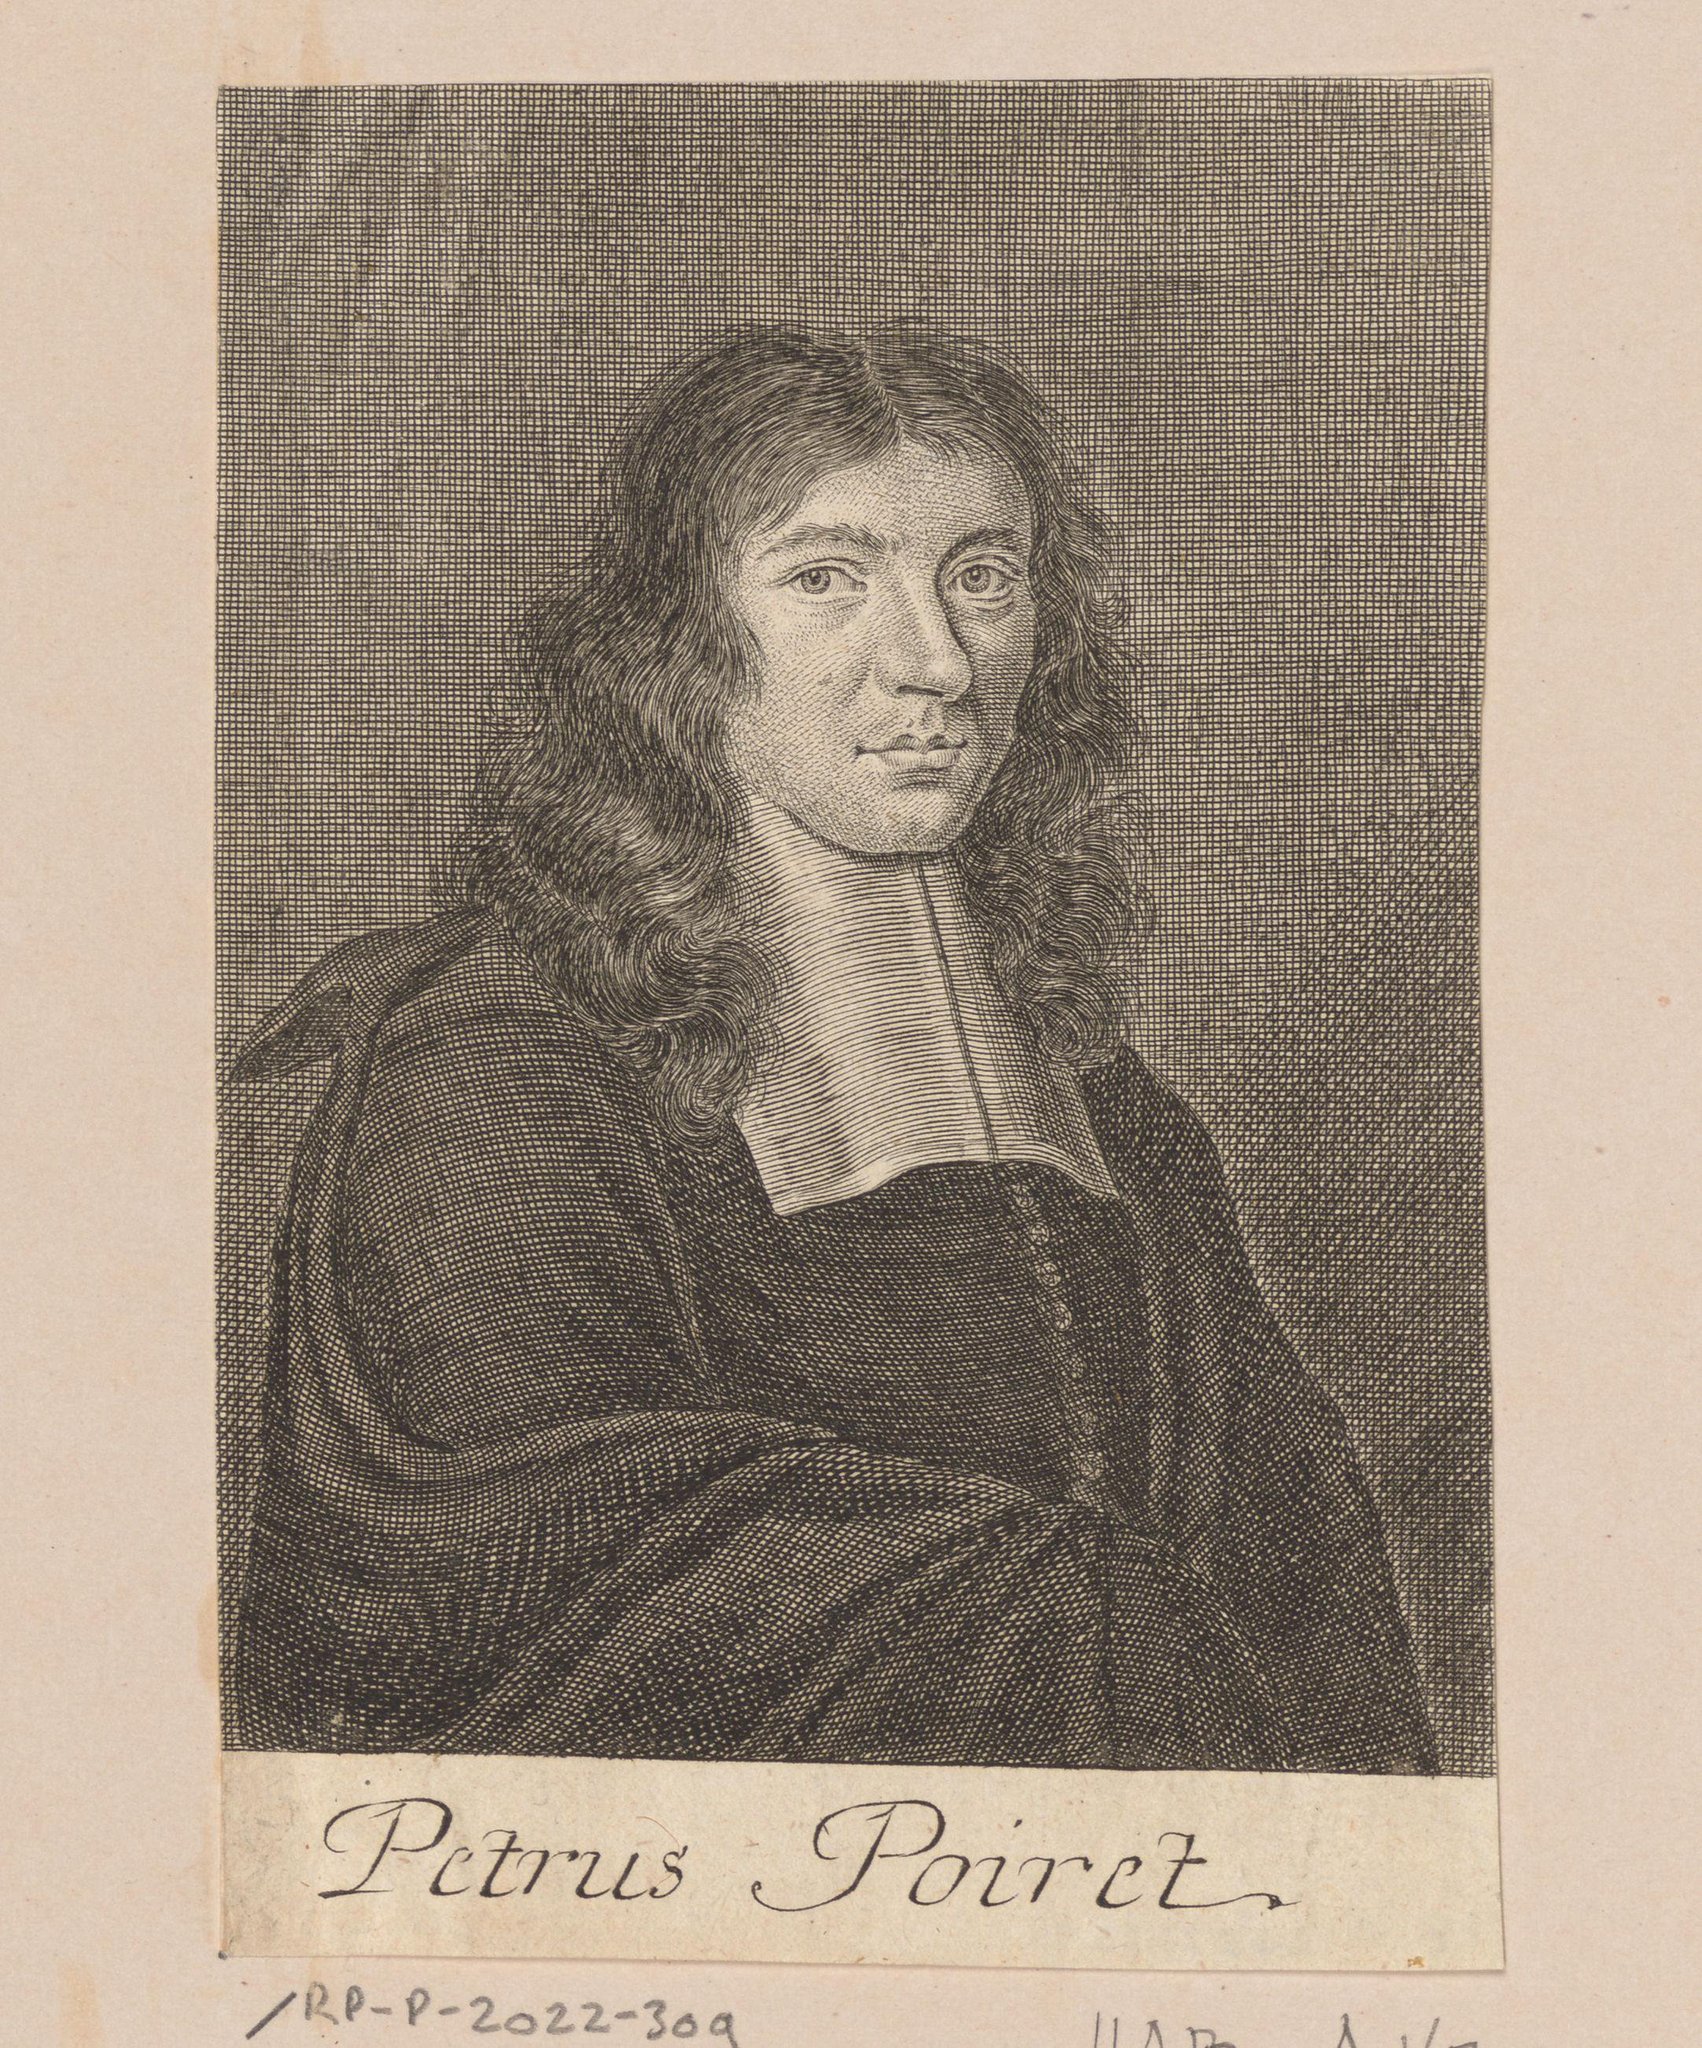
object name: print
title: Portret van Pierre Poiret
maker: martin bernigeroth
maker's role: print maker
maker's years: 1670-1733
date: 1721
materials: paper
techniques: engraving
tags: pierre poiret, theologian, historical persons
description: Prent waarschijnlijk uit: Deutsche acta eruditorum (...). Leipzig: Johann Friedrich Gleditsch en zoon, 1721, dl. 74.